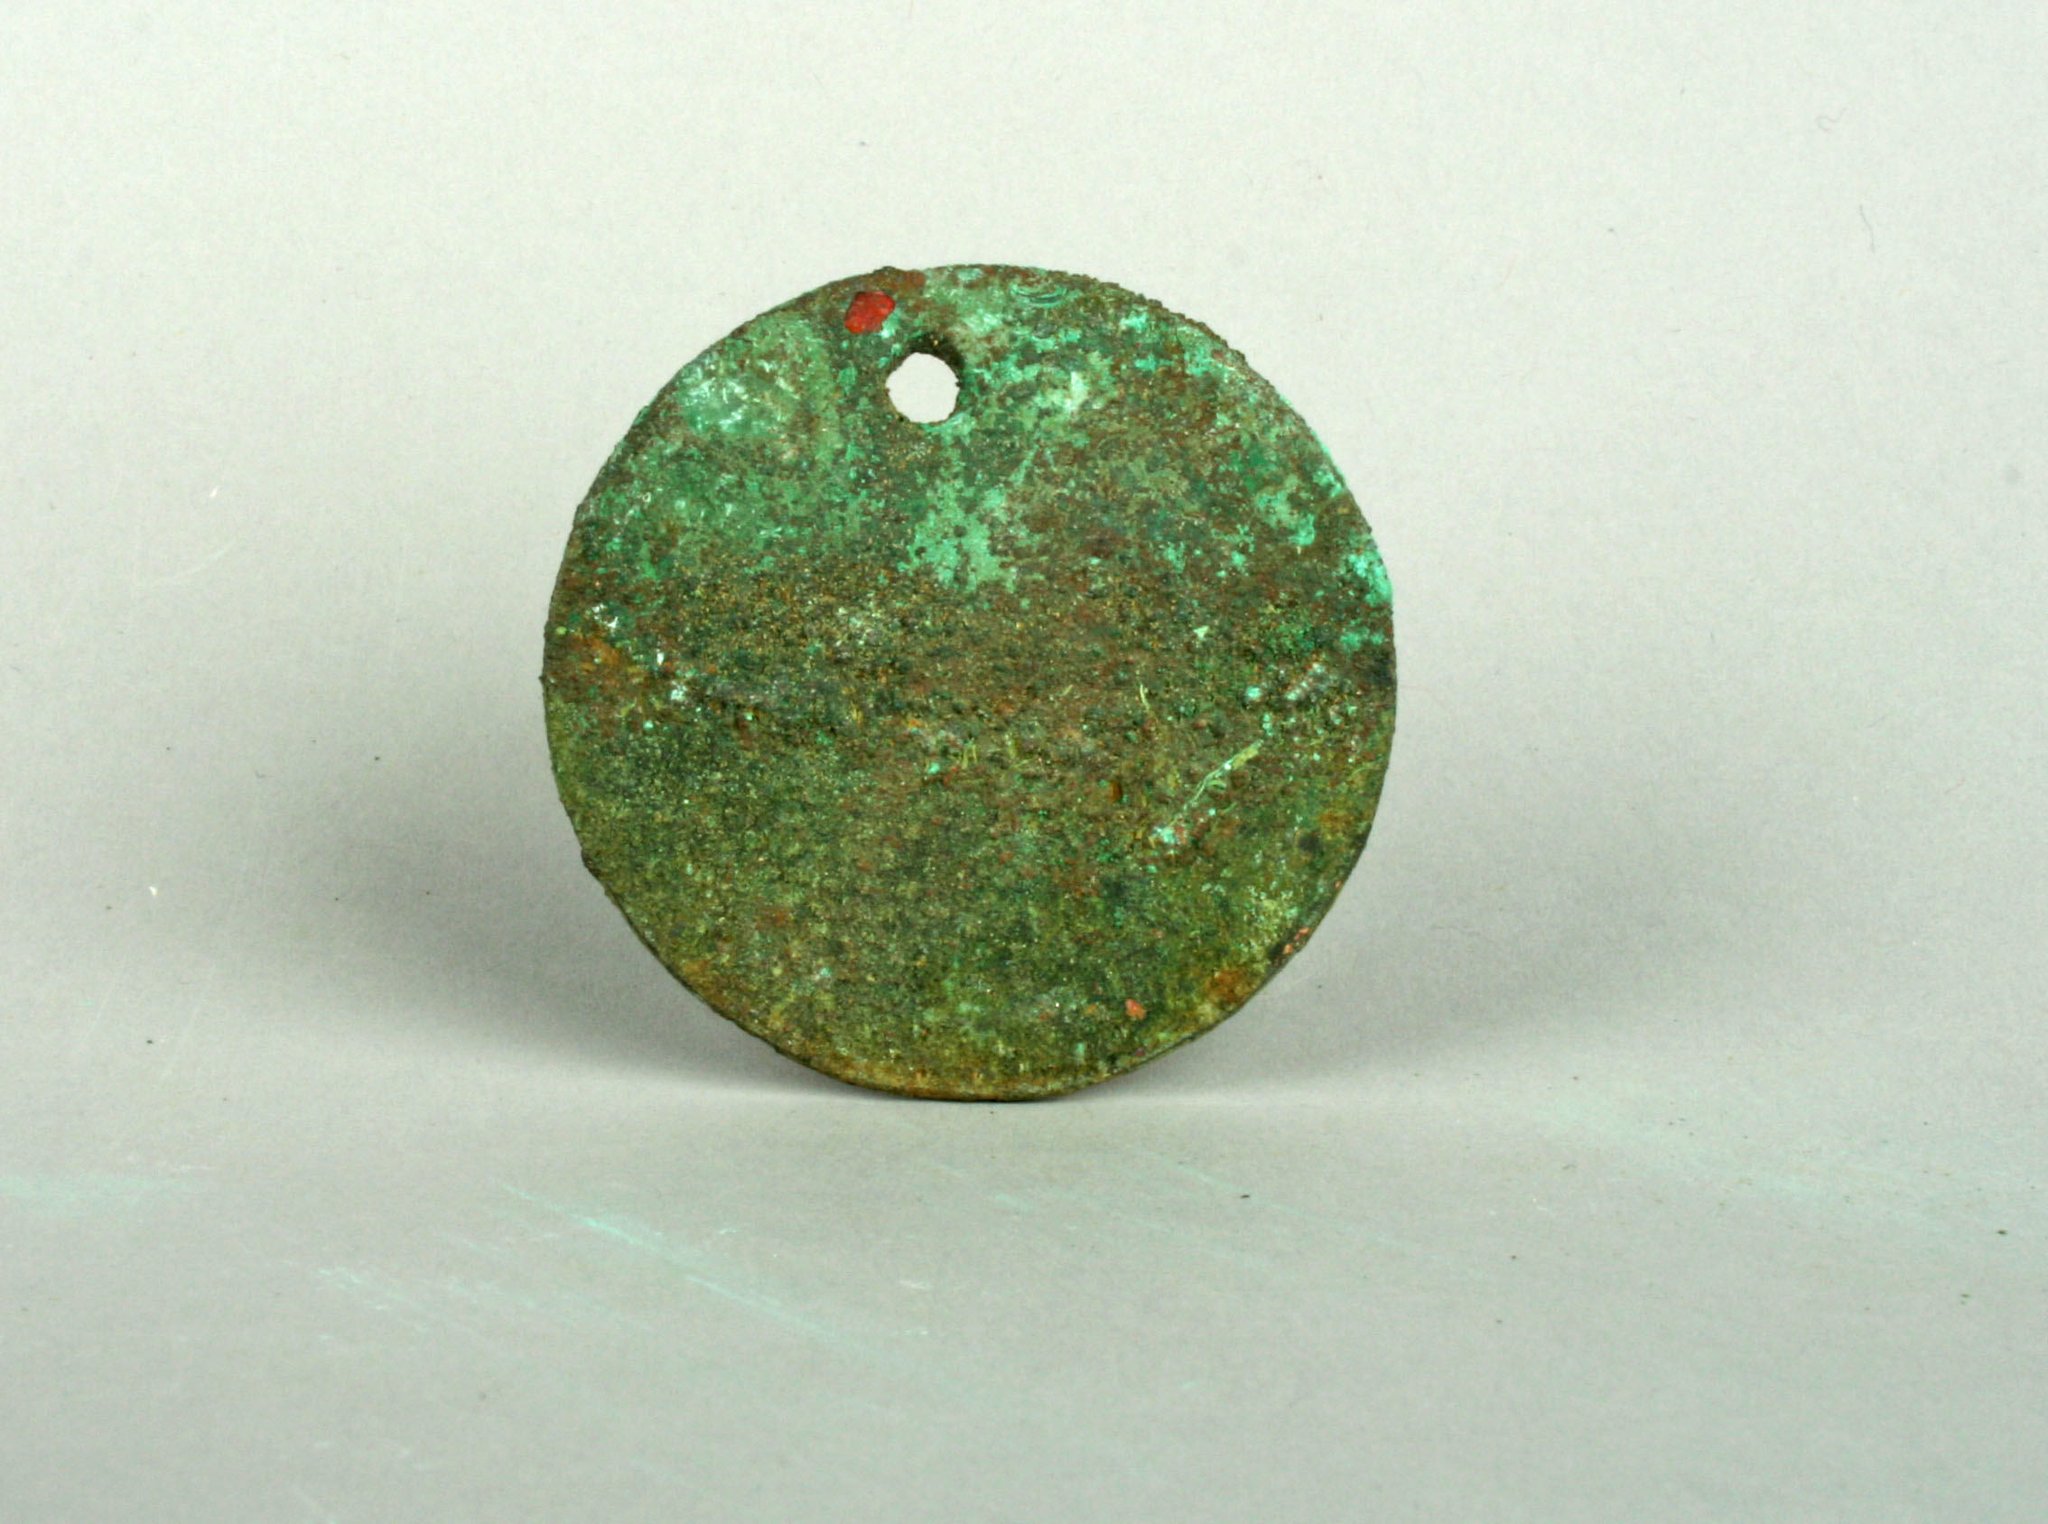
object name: plaque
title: Round Plaque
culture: vicús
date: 300 BCE-200 CE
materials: copper, gilt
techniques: hammering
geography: peru